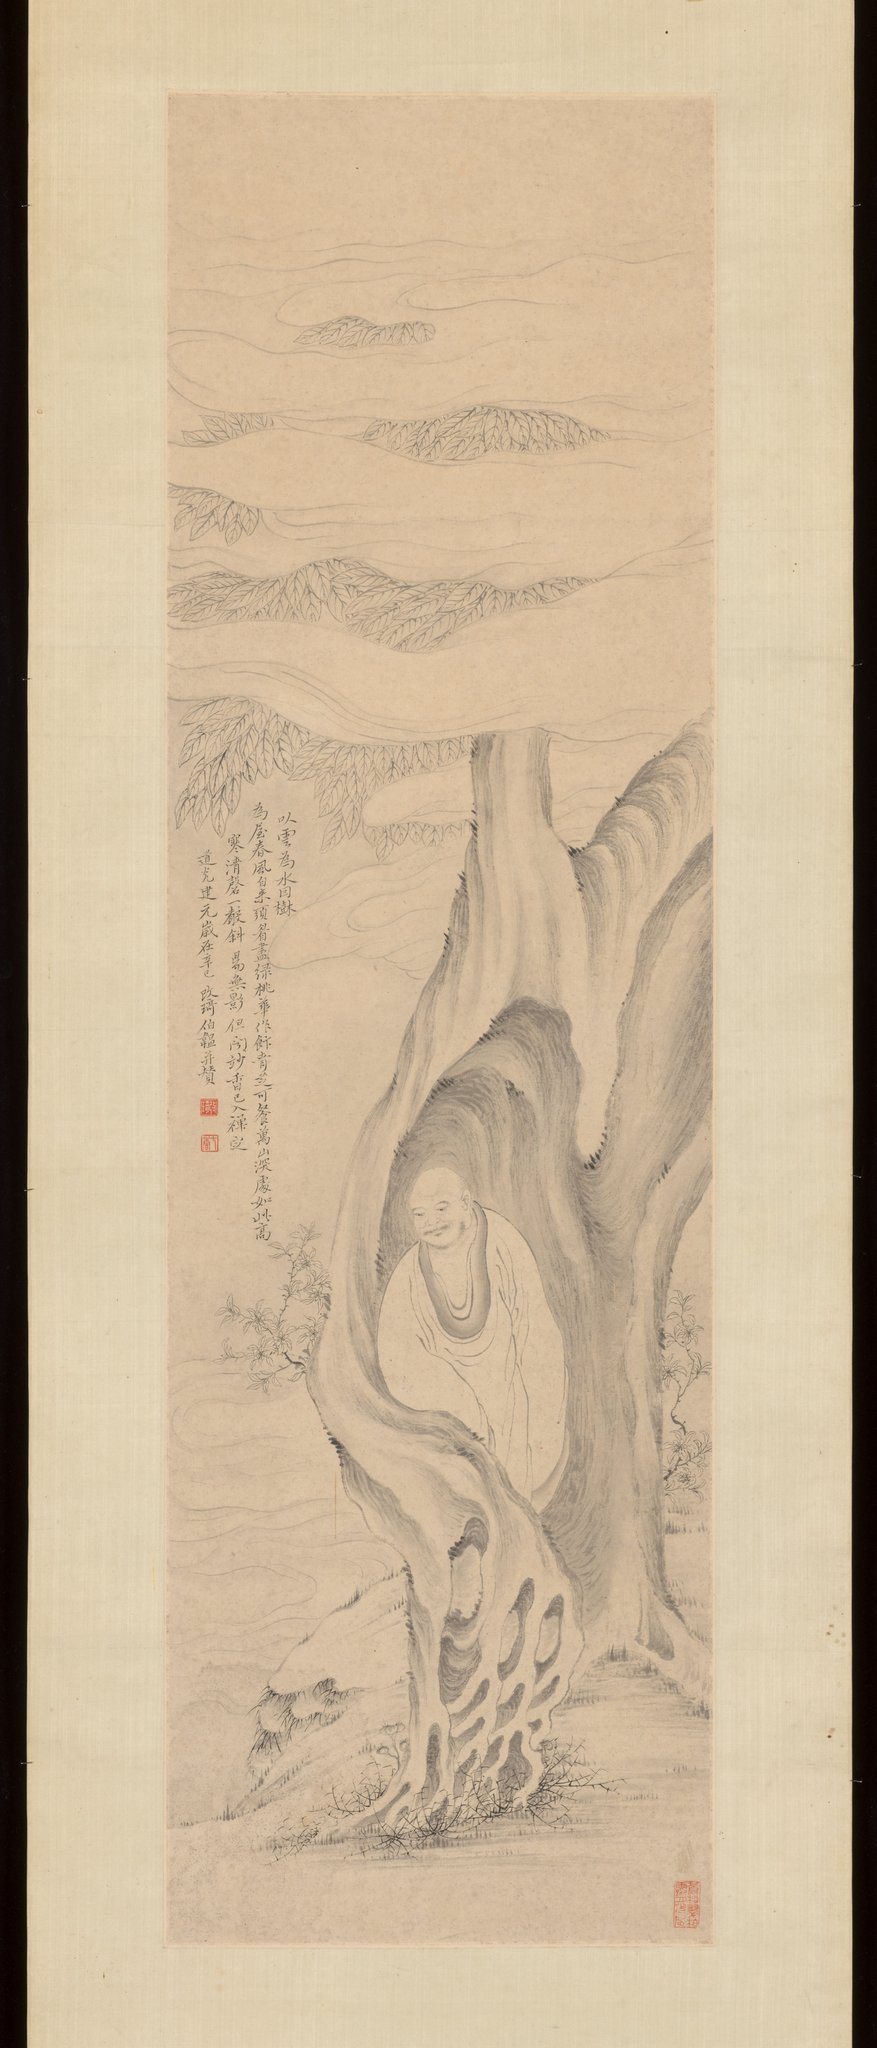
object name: hanging scroll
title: Luohan Meditating in a Tree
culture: chinese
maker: gai qi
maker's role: artist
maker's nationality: chinese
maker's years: 1773-1828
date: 1821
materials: ink, paper